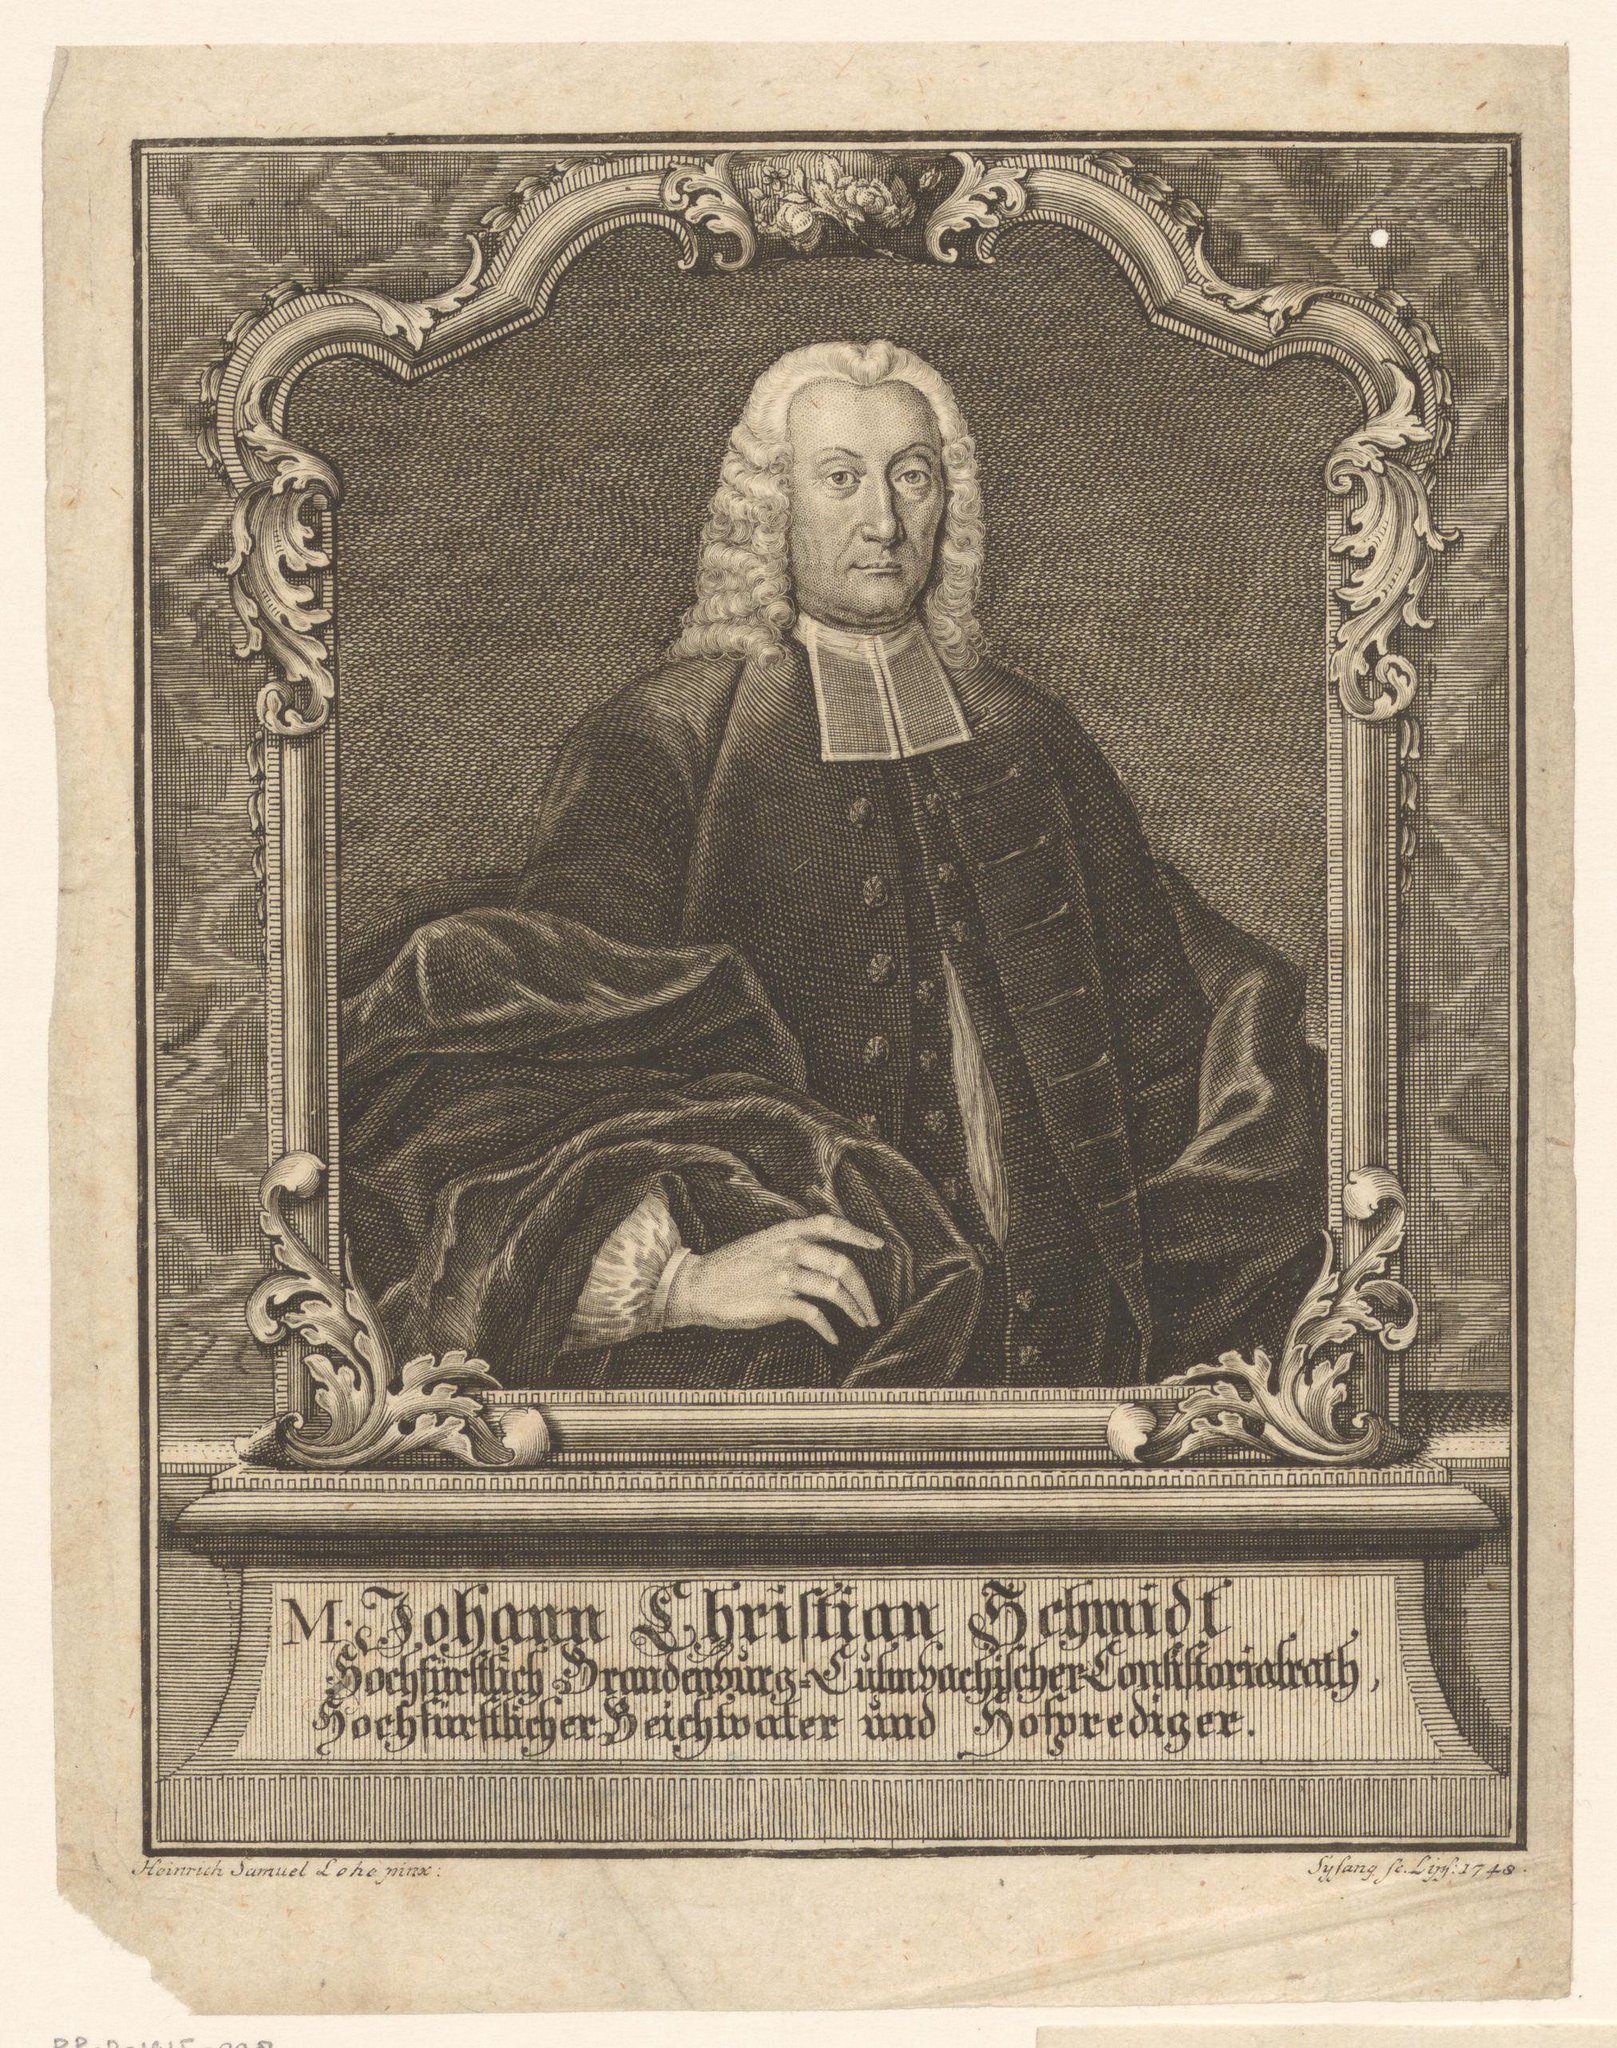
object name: print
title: Portret van Johann Christian Schmidt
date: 1748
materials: paper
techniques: engraving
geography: leipzig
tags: historical persons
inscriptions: collector's mark: Lugt 2228